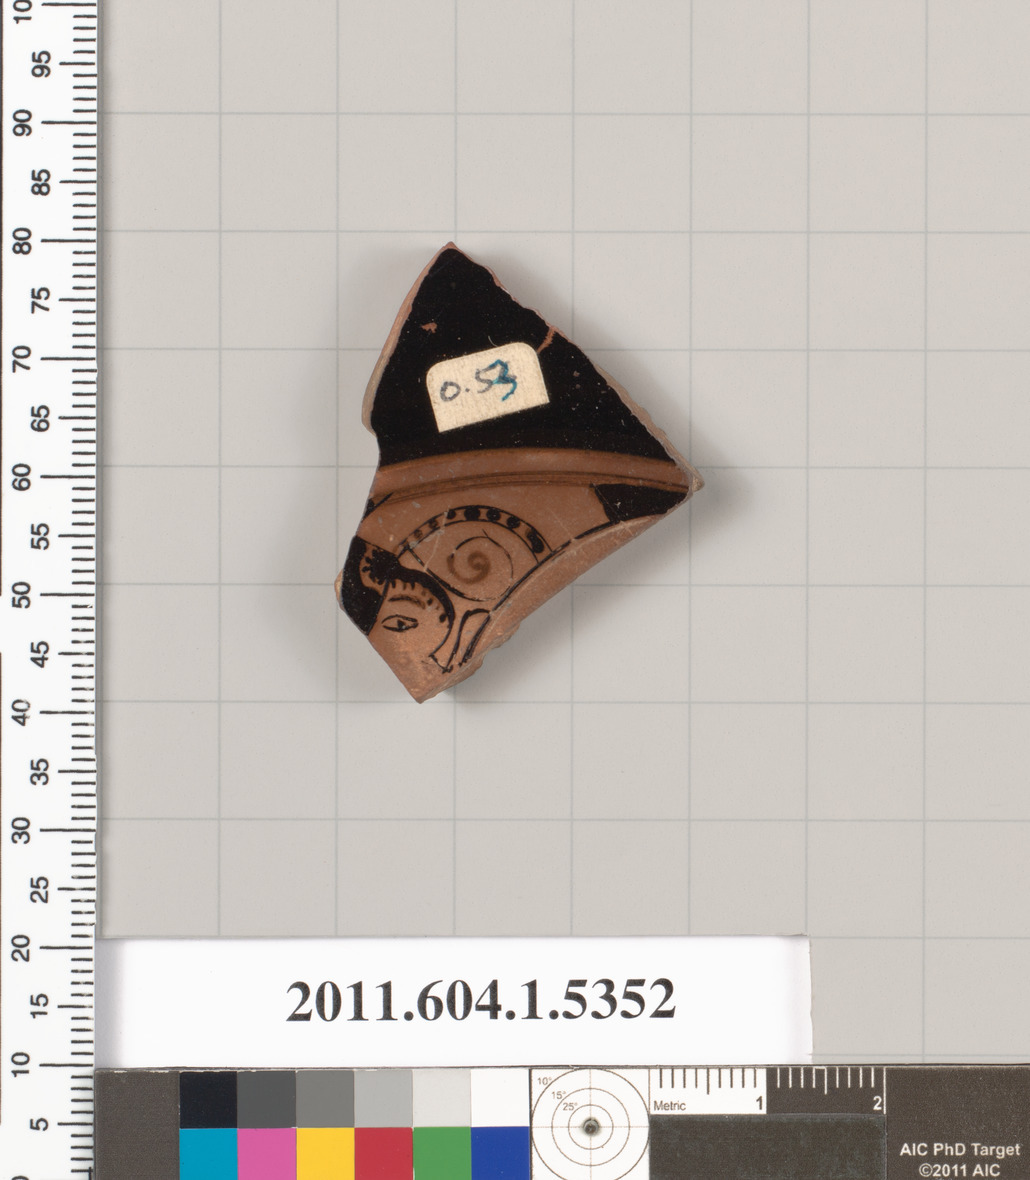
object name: kylix fragment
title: Terracotta fragment of a kylix (drinking cup)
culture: greek, attic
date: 520-510 BCE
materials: terracotta